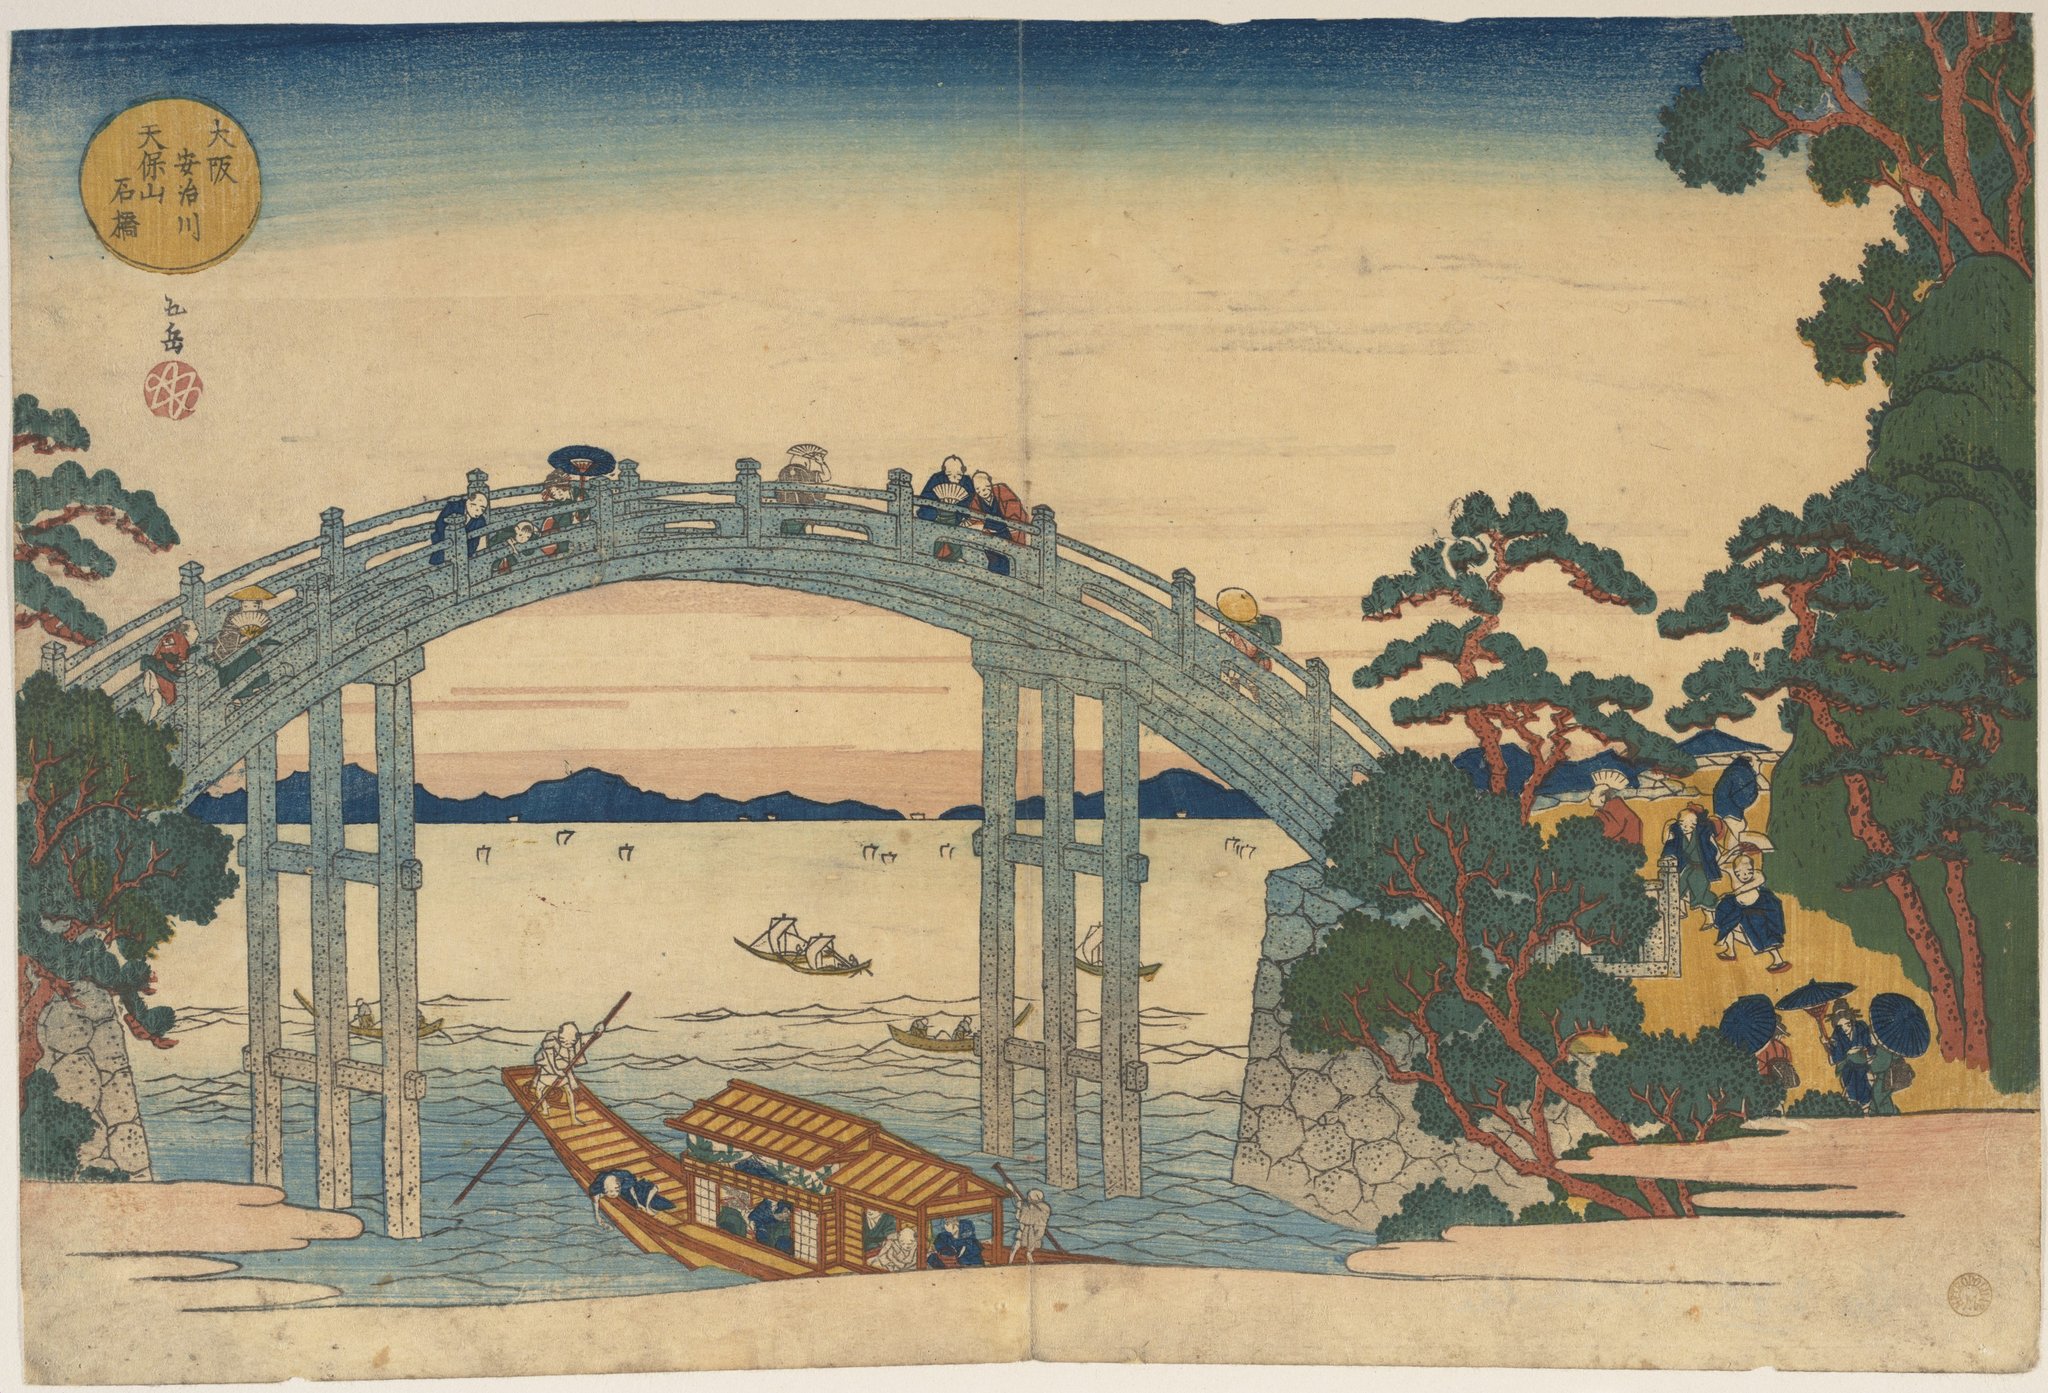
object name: print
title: Stone Bridge over the Aji River, Osaka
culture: japanese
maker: yashima gakutei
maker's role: artist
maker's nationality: japanese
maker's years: 1786-1868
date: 1838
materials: ink, paper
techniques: woodblock print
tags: human figures,bridges,mountains,trees,boats